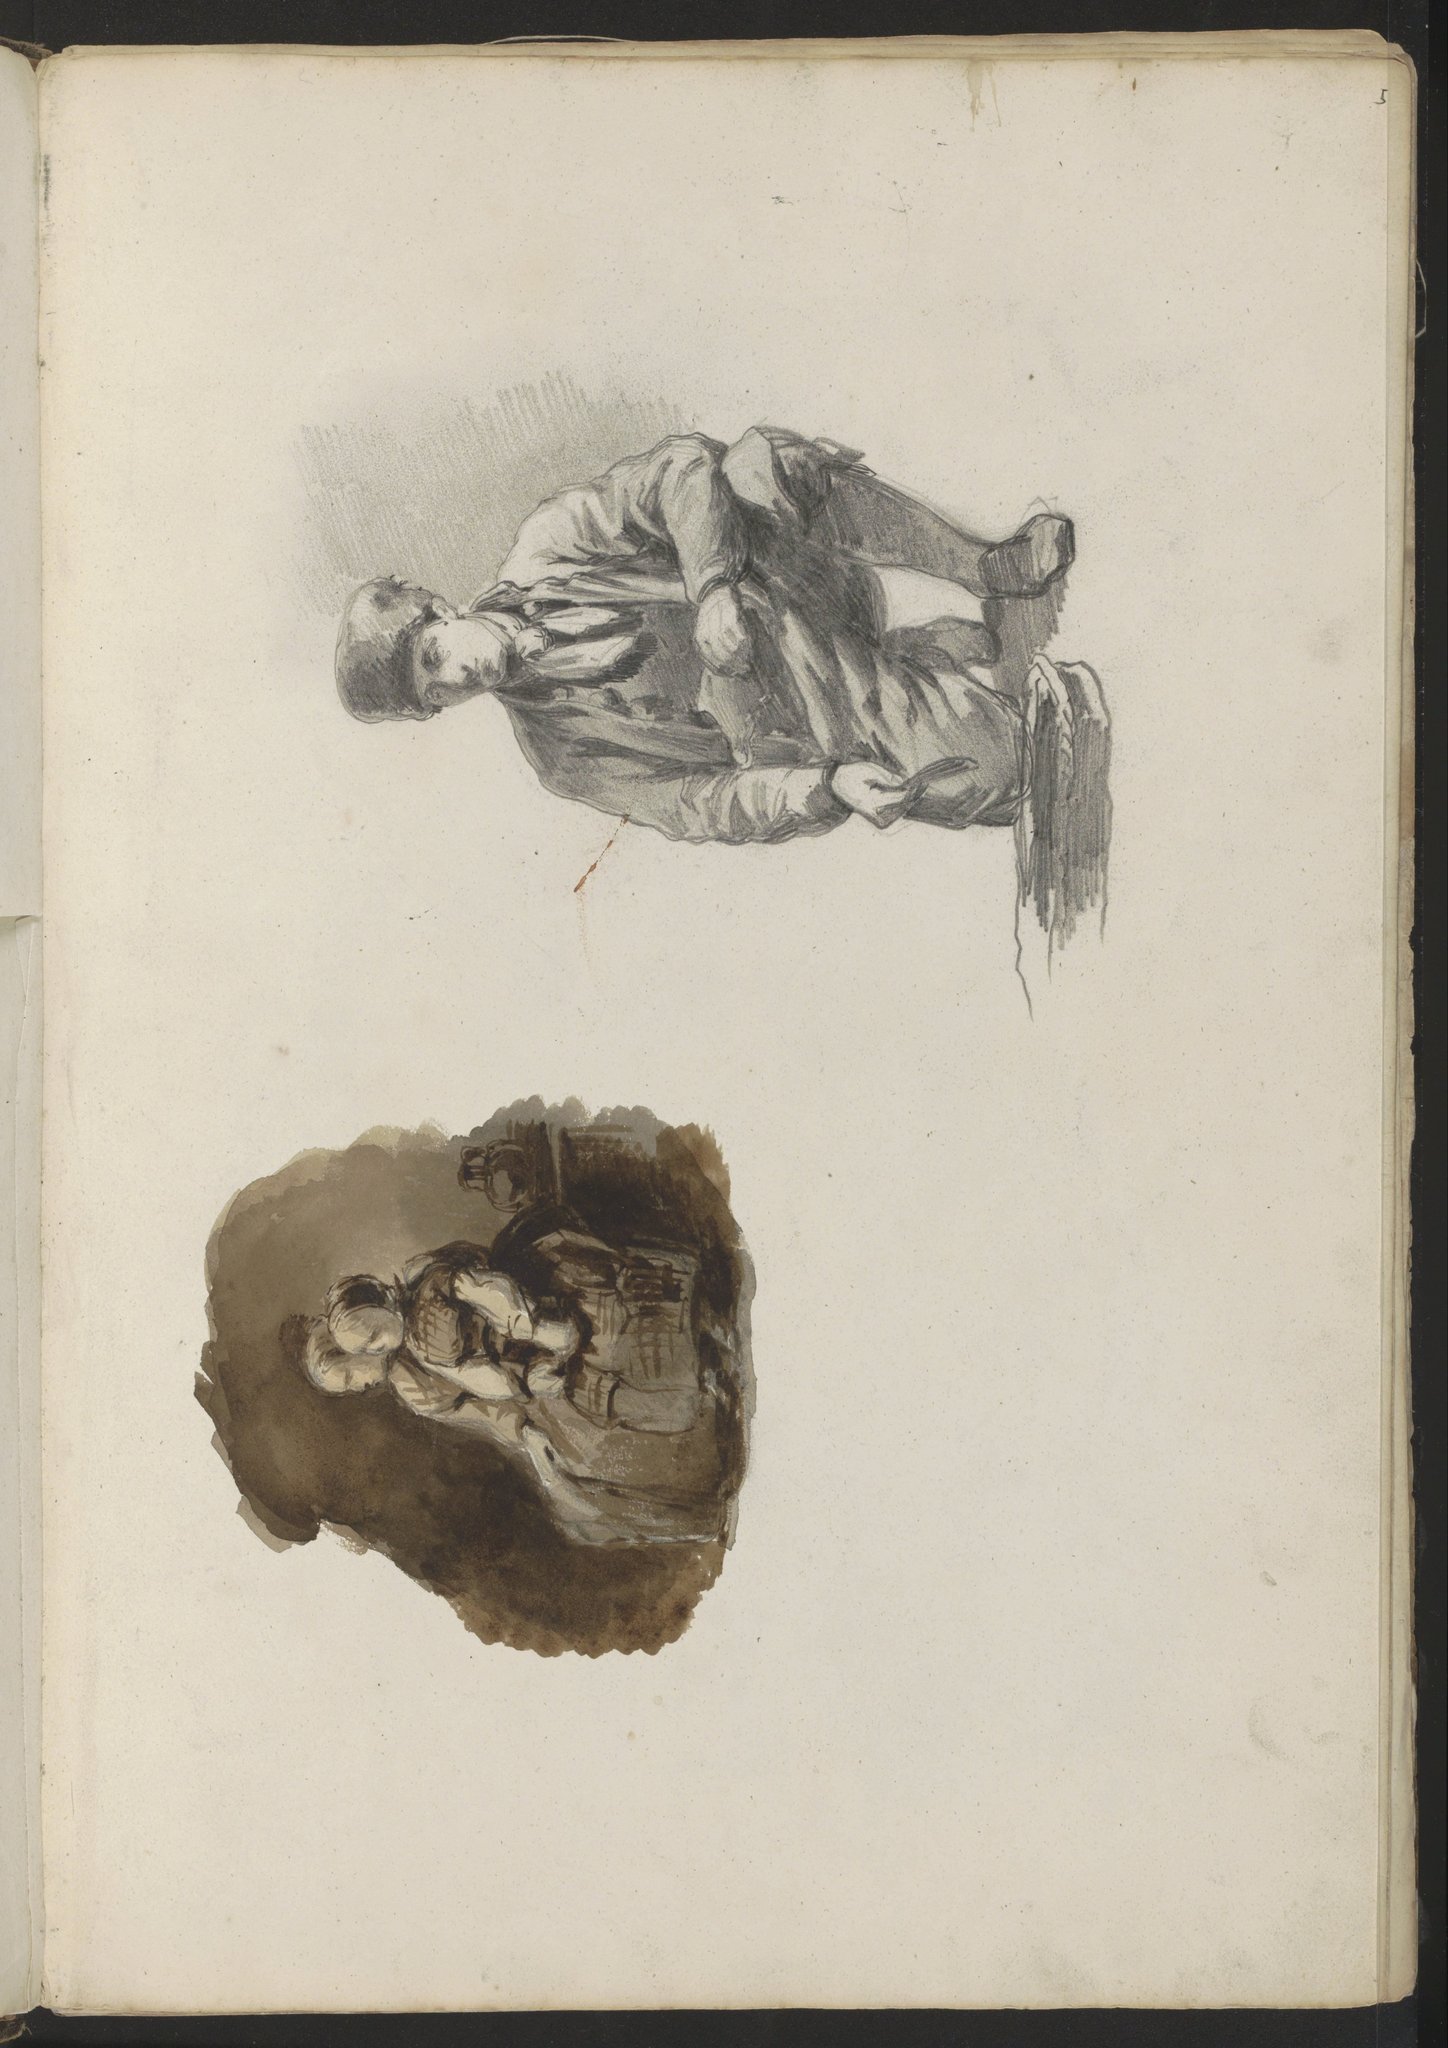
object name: sketchbook leaf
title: Knielende man en een moeder en dochter in een interieur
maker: johannes huybertus van hove bzn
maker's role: print maker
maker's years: 1827-1881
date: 1837-1881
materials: paper, pencil, watercolor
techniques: brush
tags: interior of the house, mother and daughter(s) (family group), kneeling figure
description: Blad 5 recto uit een schetsboek met 33 bladen en 10 losse tekeningen.